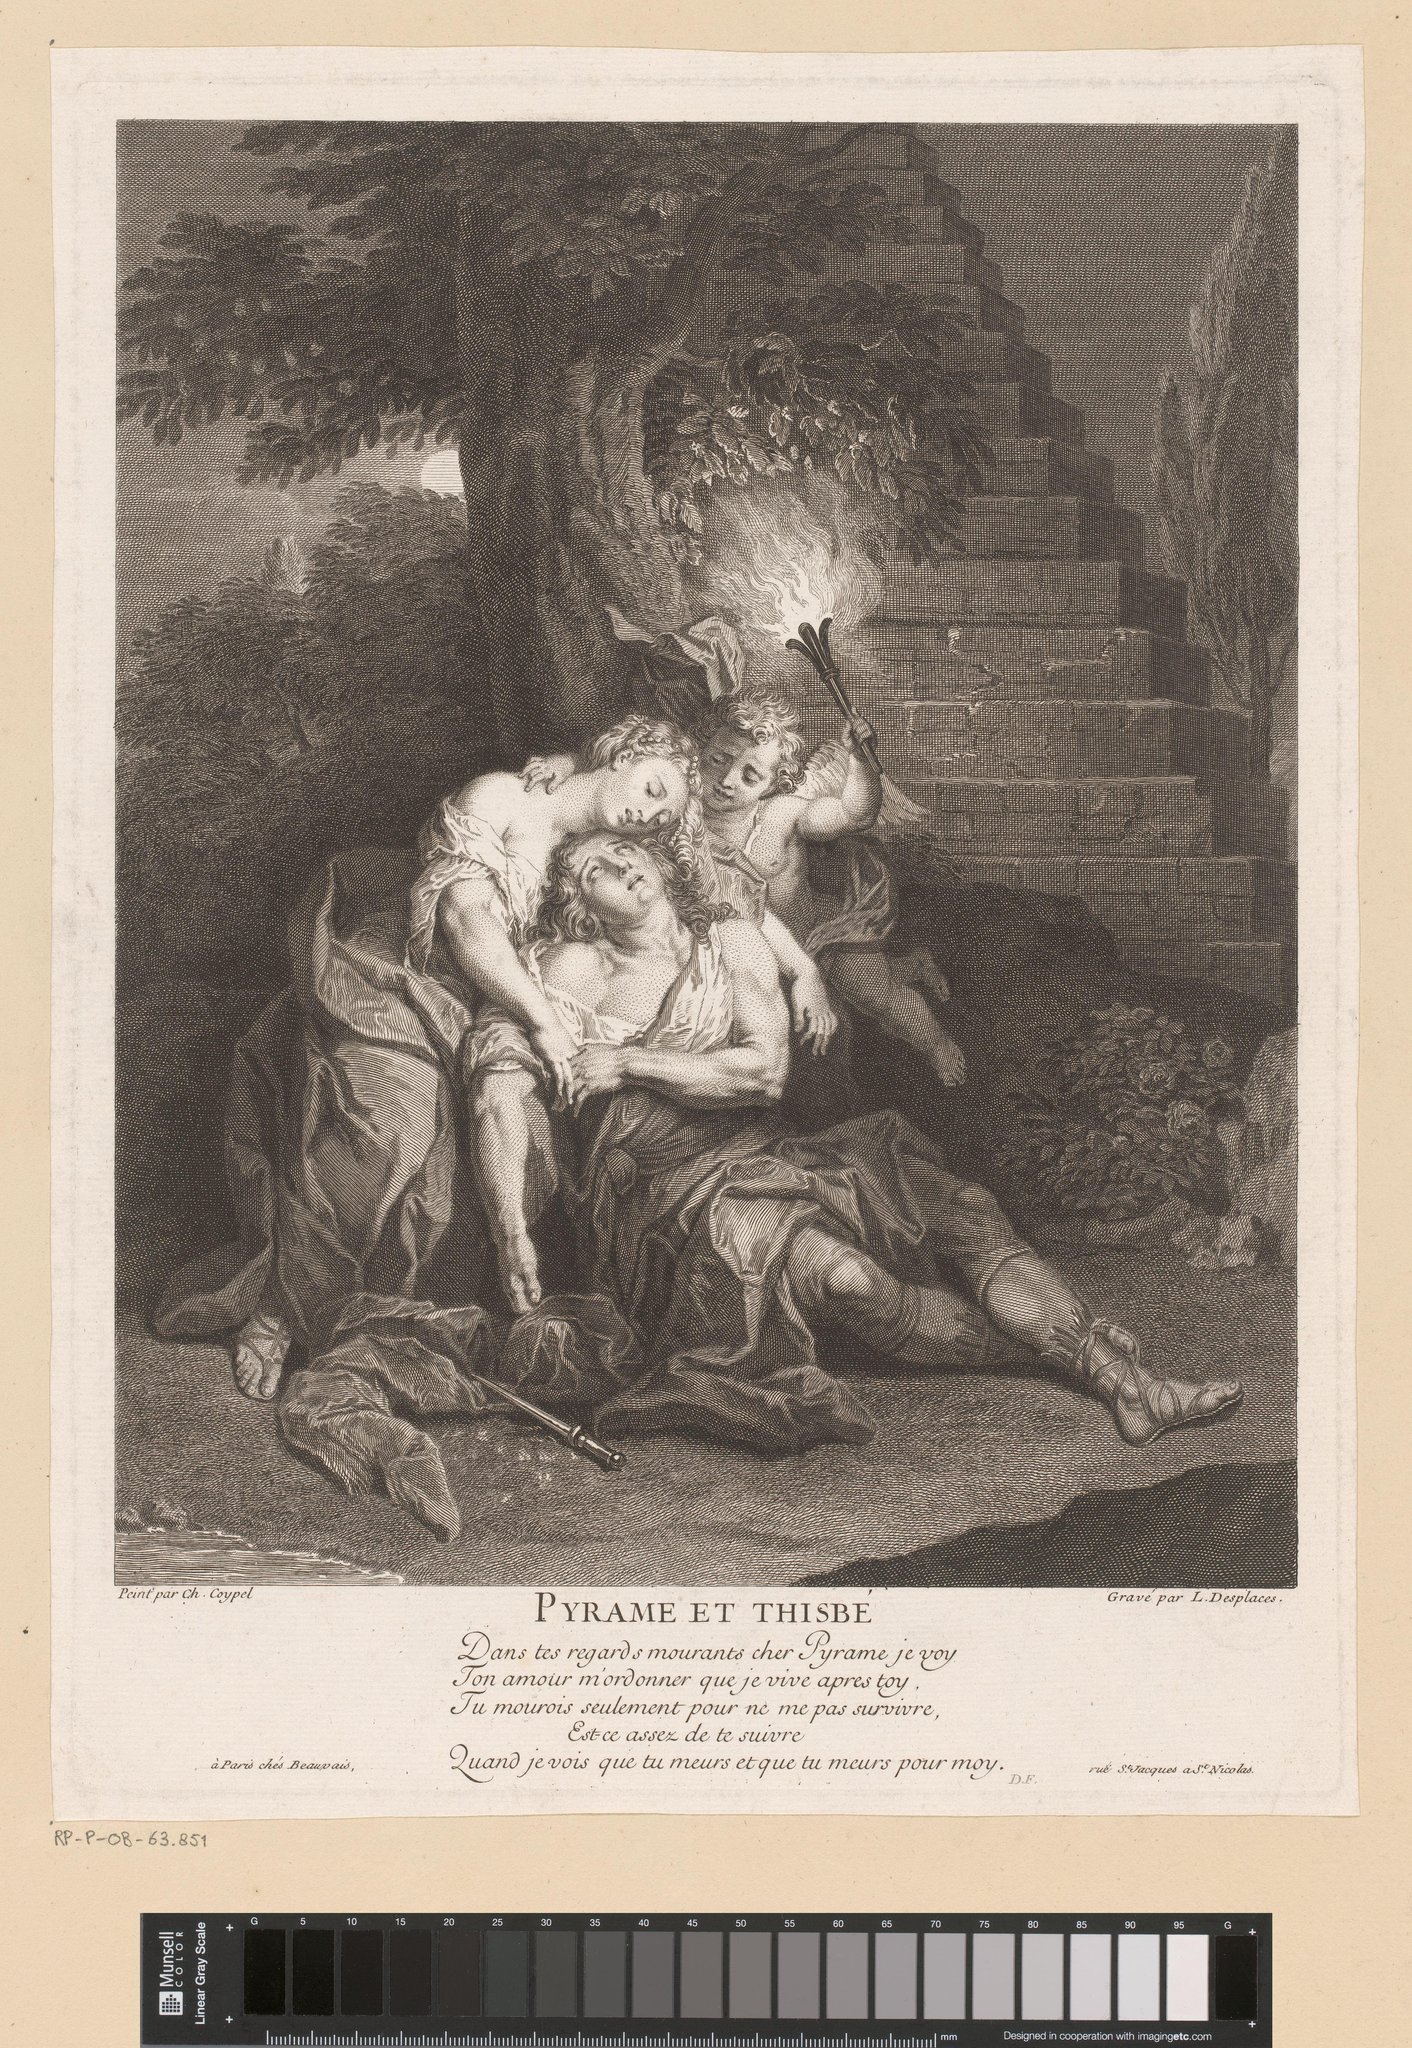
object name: print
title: Pyramus en Thisbe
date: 1697-1739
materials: paper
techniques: engraving, etching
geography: paris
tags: (story of) pyramus and thisbe - death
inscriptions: collector's mark: Lugt 240